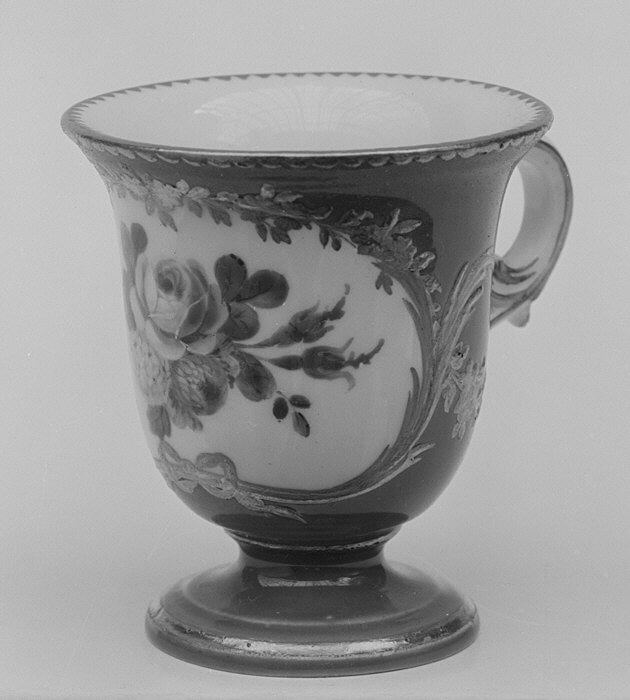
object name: ice cream cup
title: Ice cream cup (tasse à glace) (one of thirty-one) (part of a service)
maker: sèvres manufactory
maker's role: manufactory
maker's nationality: french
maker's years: 1740-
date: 1771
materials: soft paste porcelain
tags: flowers